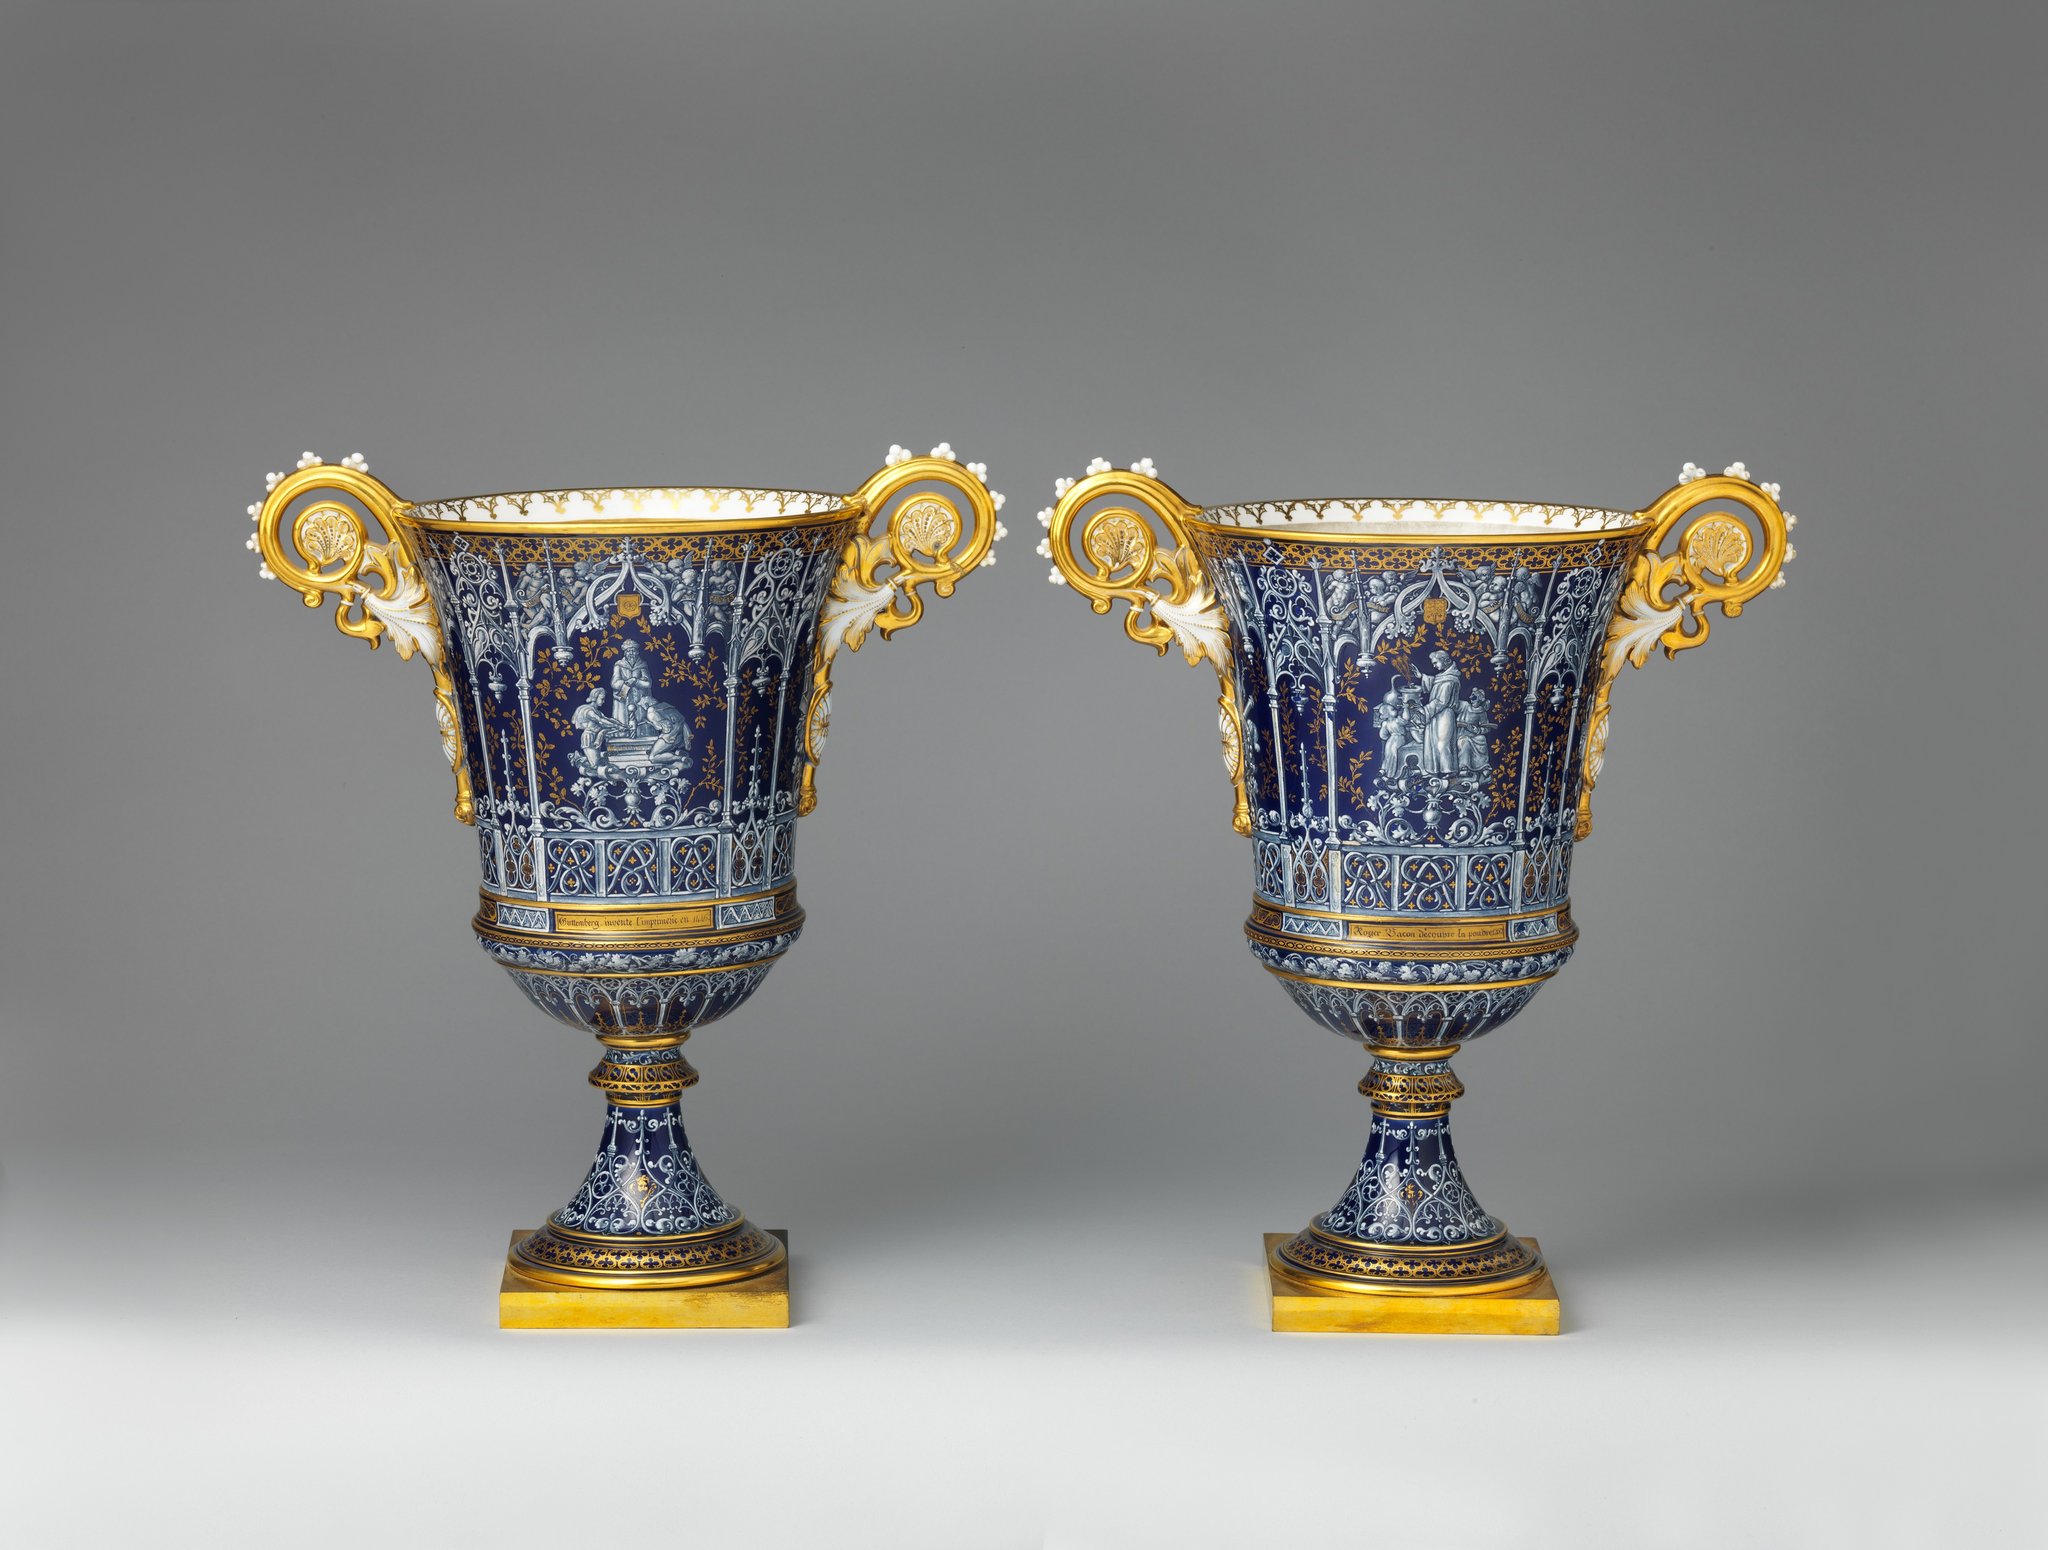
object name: vase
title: Vase (vase gothique Fragonard) (one of a pair)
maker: alexandre evariste fragonard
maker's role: designer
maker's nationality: french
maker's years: 1780-1850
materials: enamel, gilt bronze, gold, hard paste porcelain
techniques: polychrome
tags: men,putti